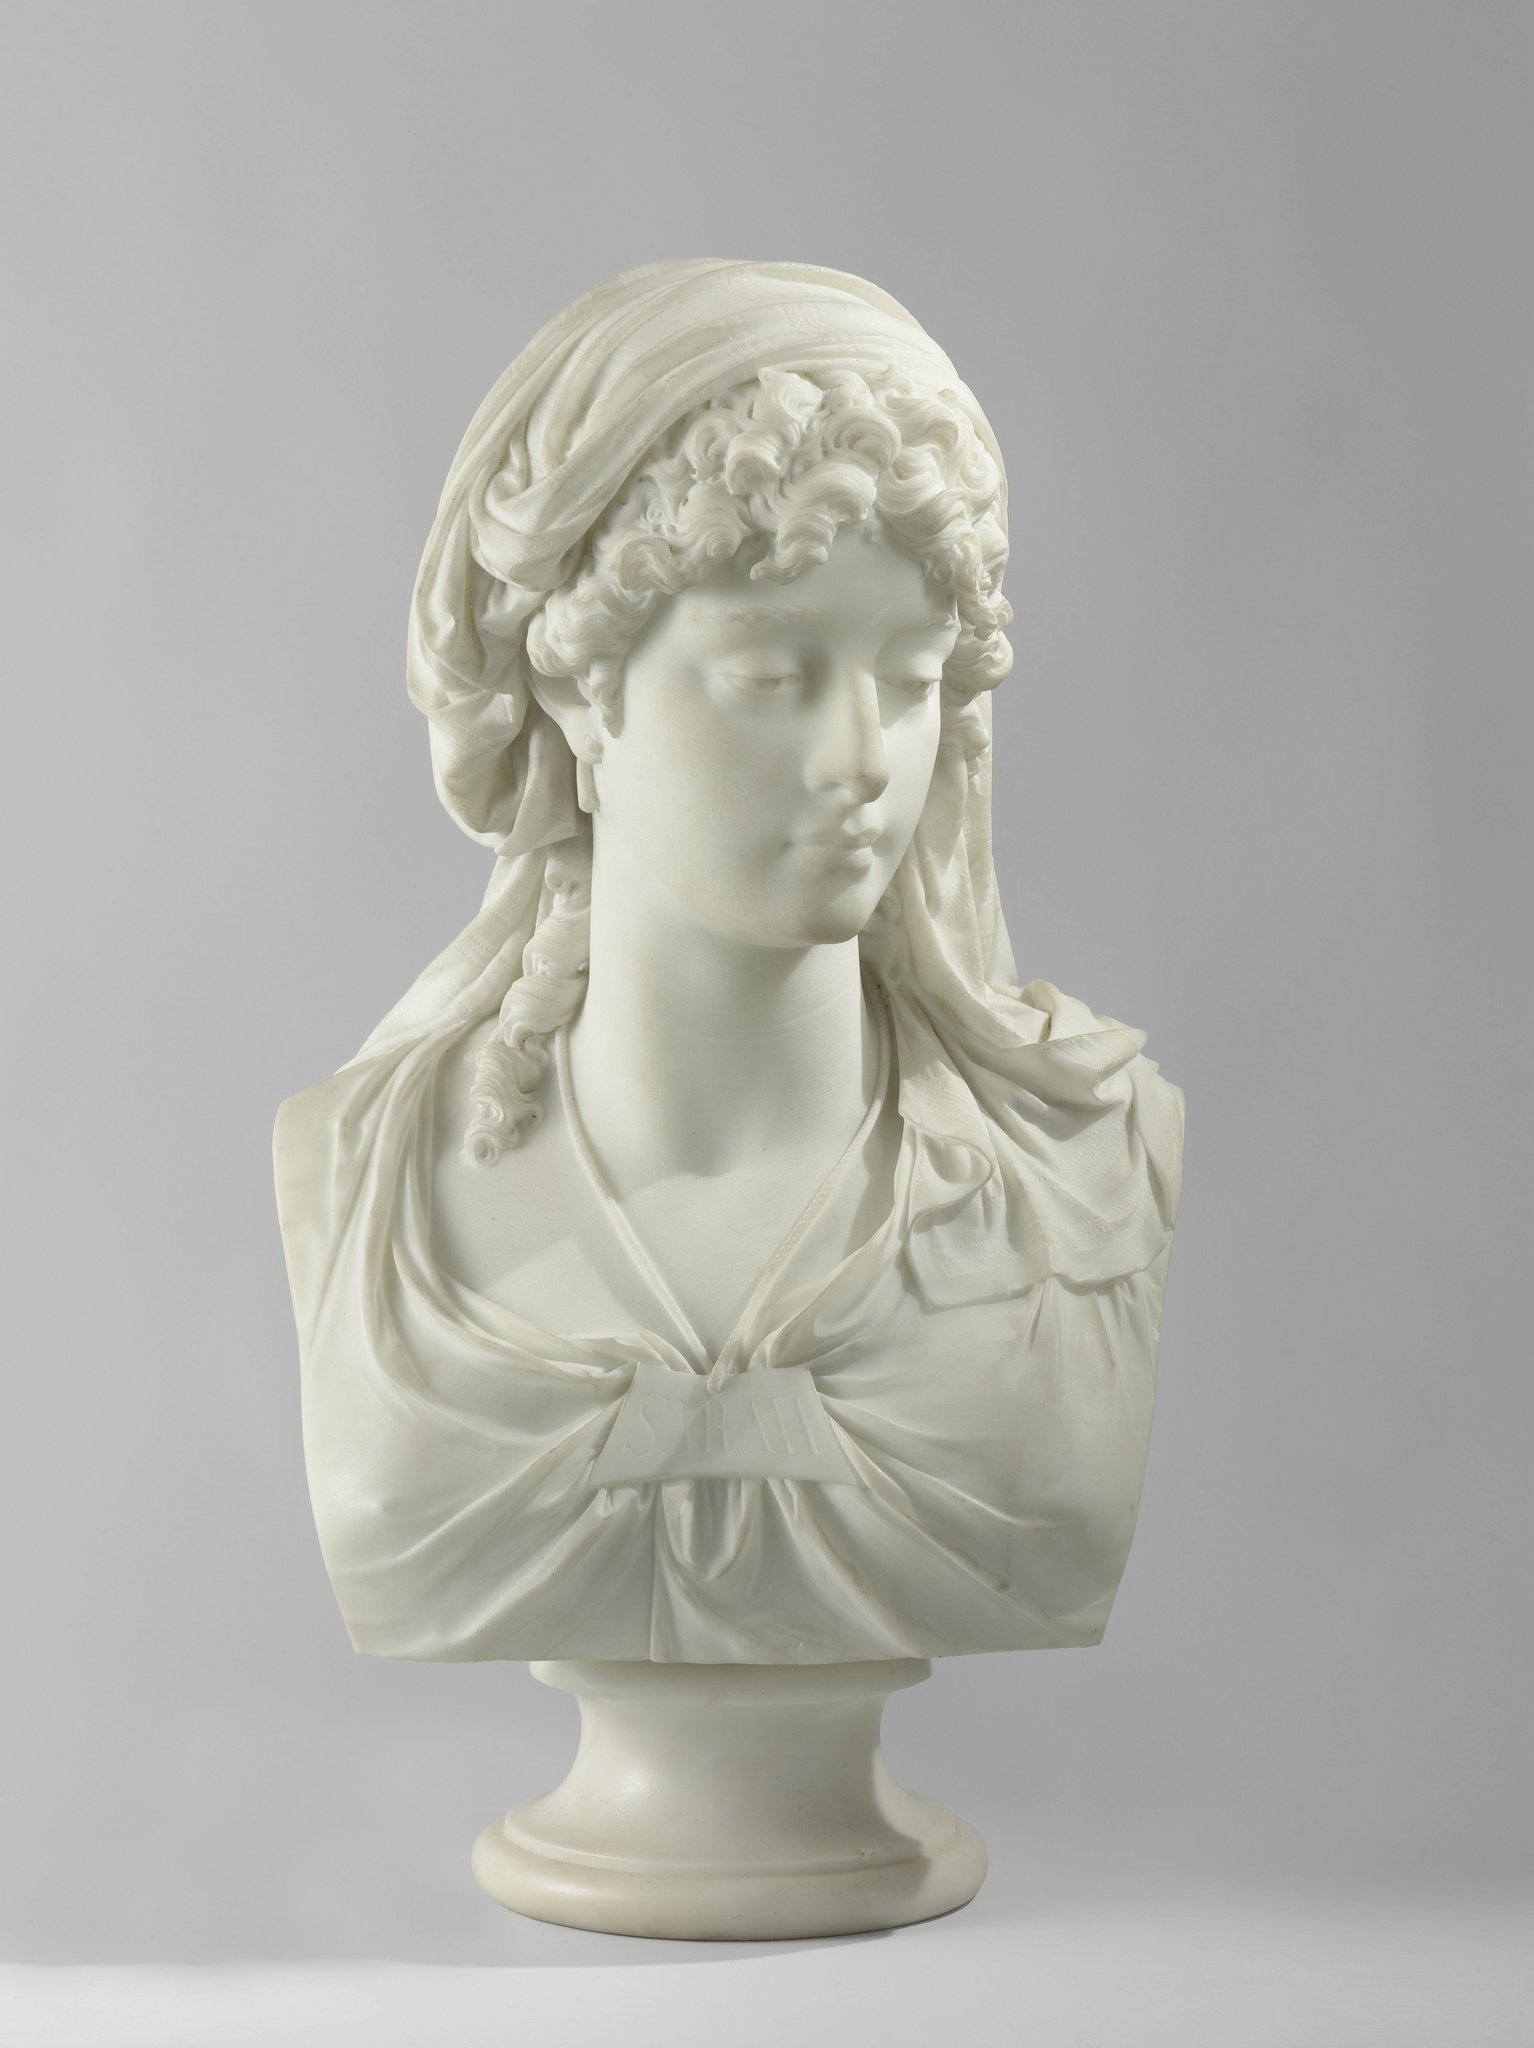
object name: sculpture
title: Sarah Bernhardt (1843-1923)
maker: frans stracké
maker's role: draughtsman, painter, sculptor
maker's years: 1820-1898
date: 1877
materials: marble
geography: amsterdam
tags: paris, sculptor, sarah bernhardt, historical persons - bb - woman (+ (full) bust portrait)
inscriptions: inscription: ‘SARAH’, signature: ‘F. STRACKE, AMSTERDAM’